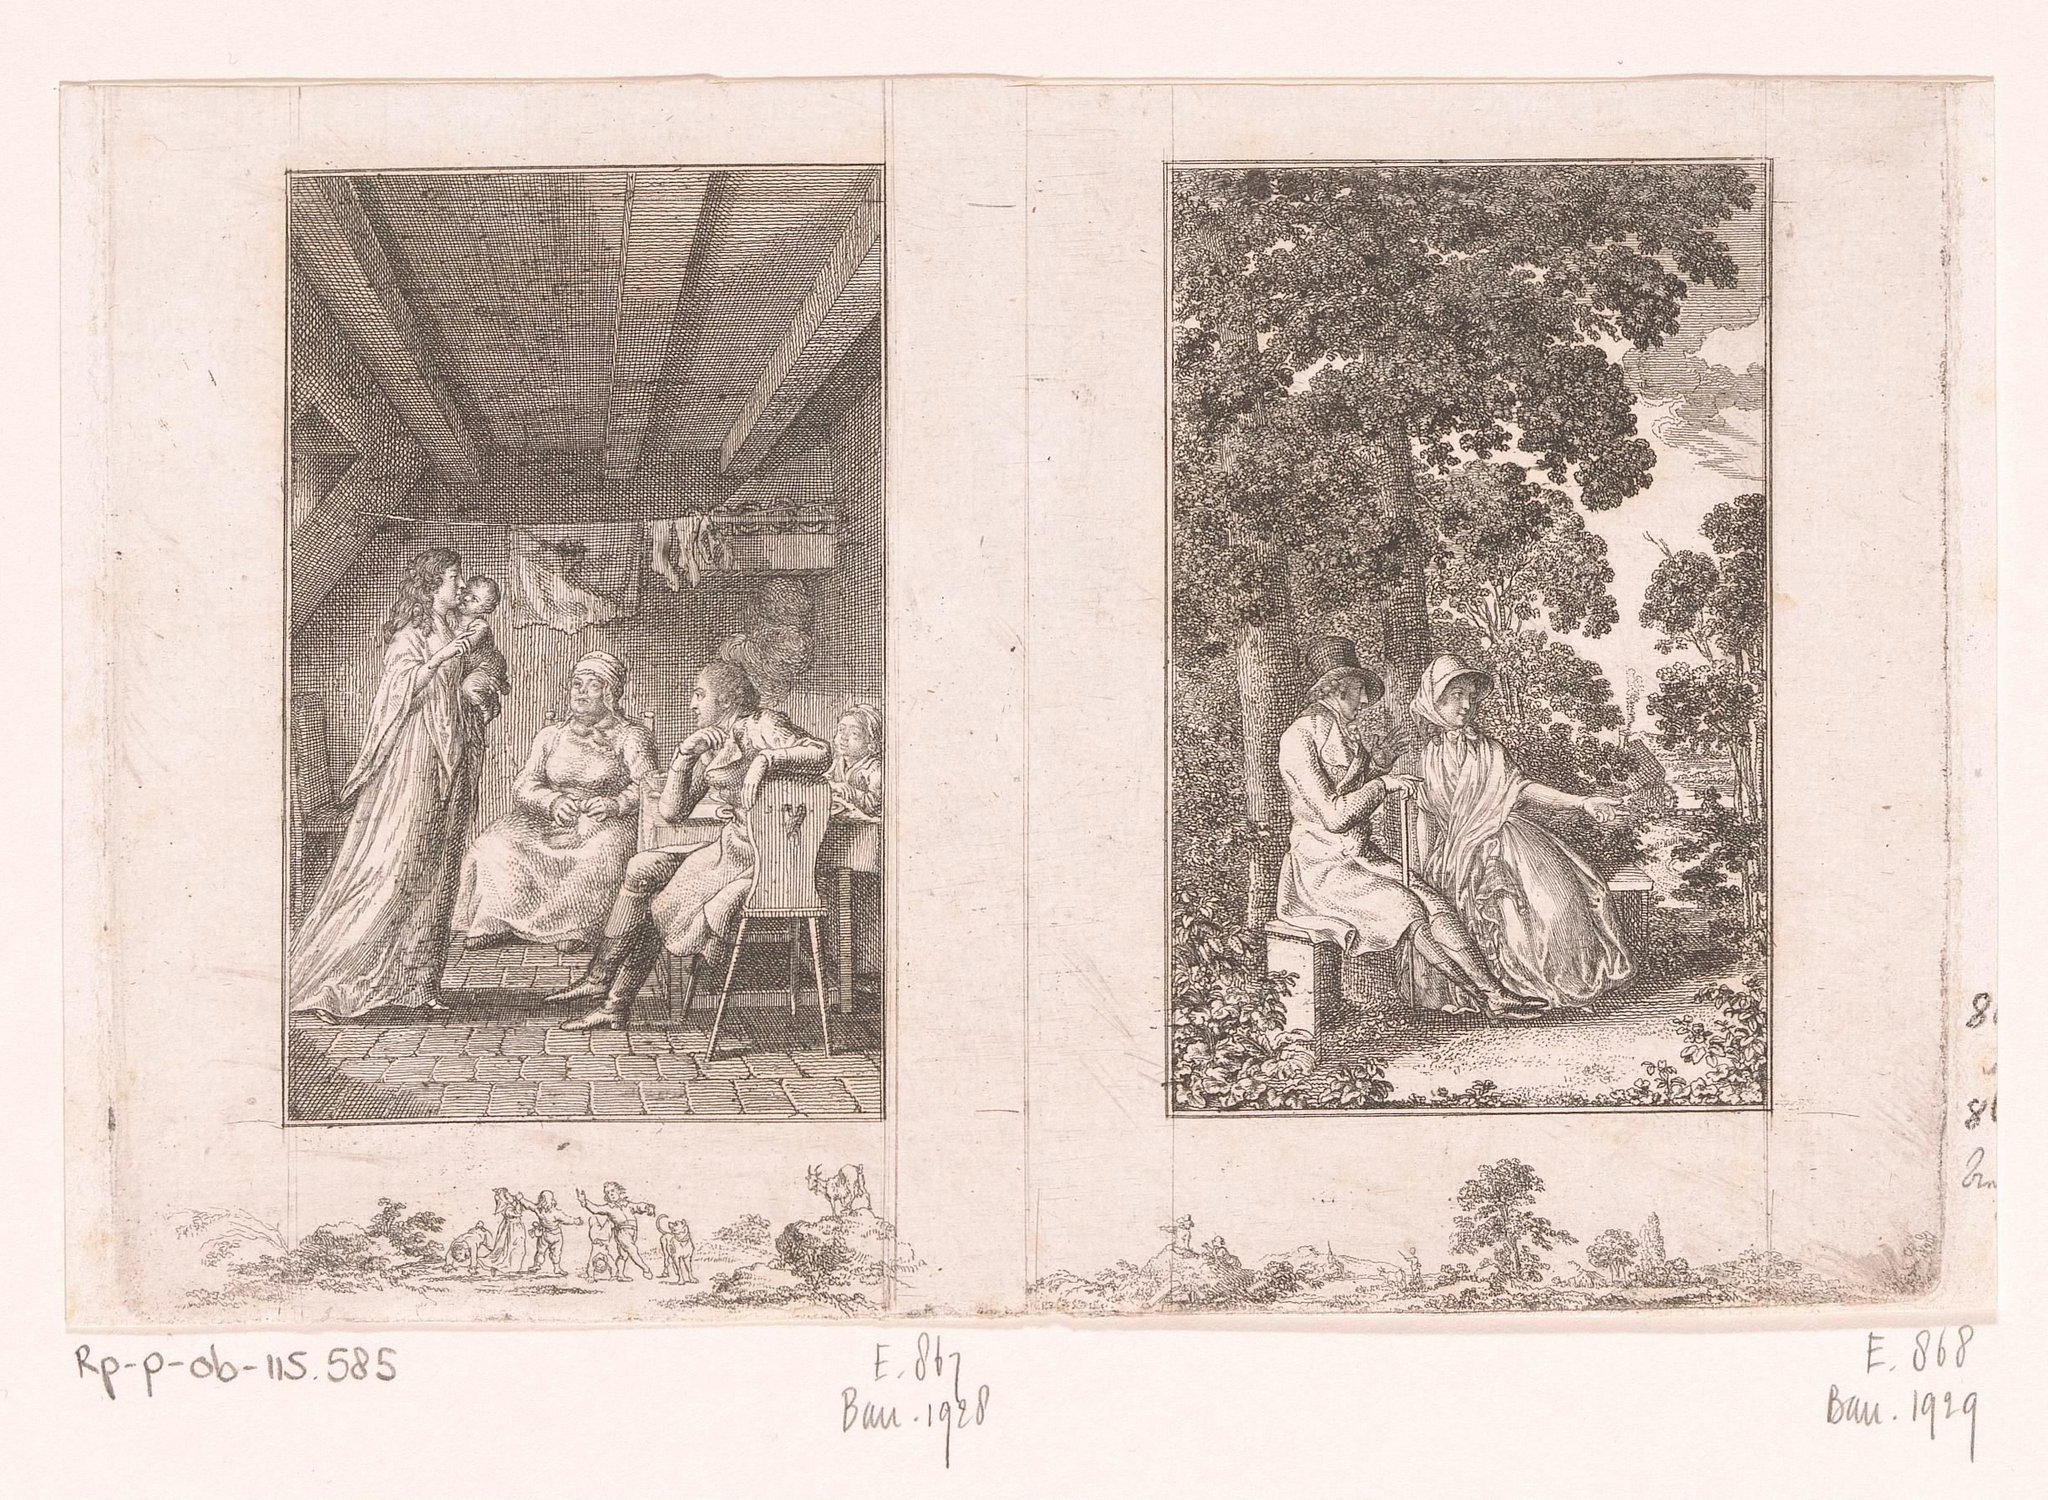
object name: print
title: Twee voorstellingen uit de verhalen van Wilhelm Gottlieb Becker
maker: daniel nikolaus chodowiecki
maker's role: draughtsman, print maker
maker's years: 1726-1801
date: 1798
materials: paper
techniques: etching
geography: berlin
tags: bench, travelling; tourism, mother and baby or young child, lovers' meeting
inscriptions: collector's mark: Lugt 2228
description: Prent gebruikt voor: Becker, Wilhelm Gottlieb. Almanach und Taschenbuch zum geselligen Vergnügen von W. G. Becker für 1799. Leipzig: Voss und Comp., 1798.